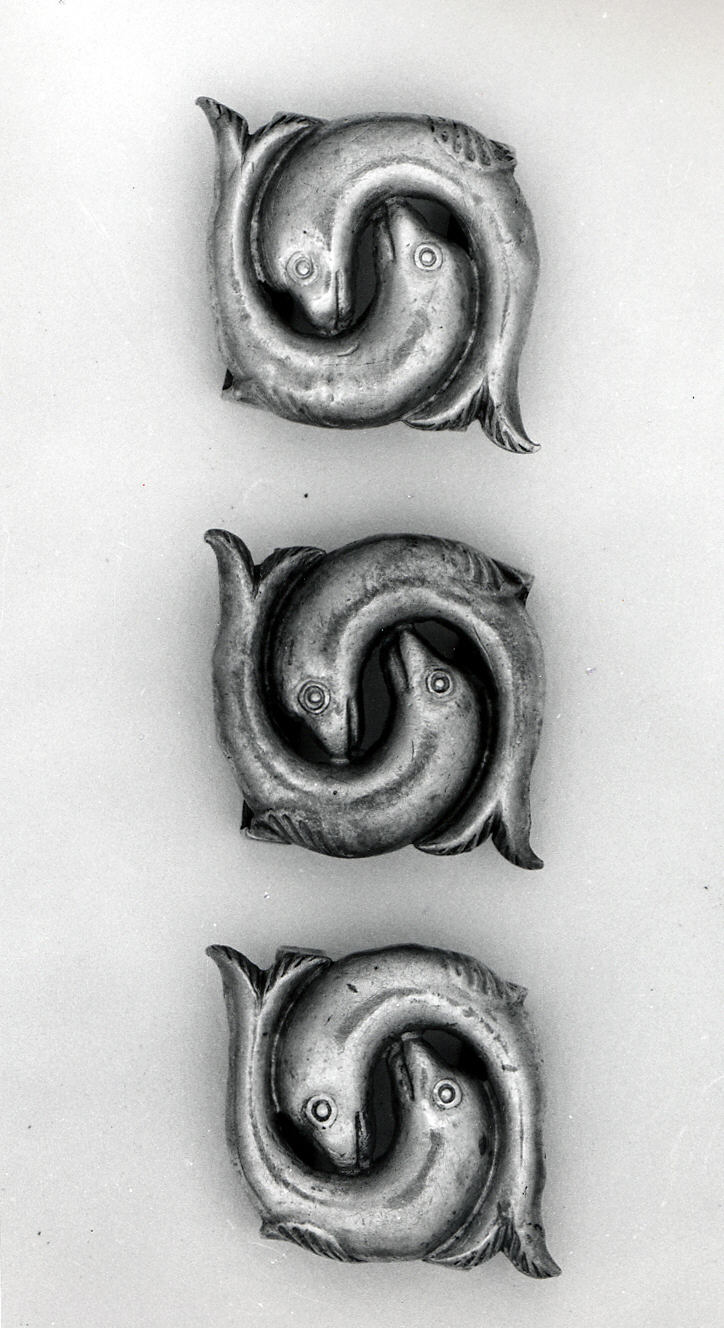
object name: ornament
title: Three Ornaments from a Bridle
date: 1634-1666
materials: silver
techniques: gilding, stamping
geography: india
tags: fish